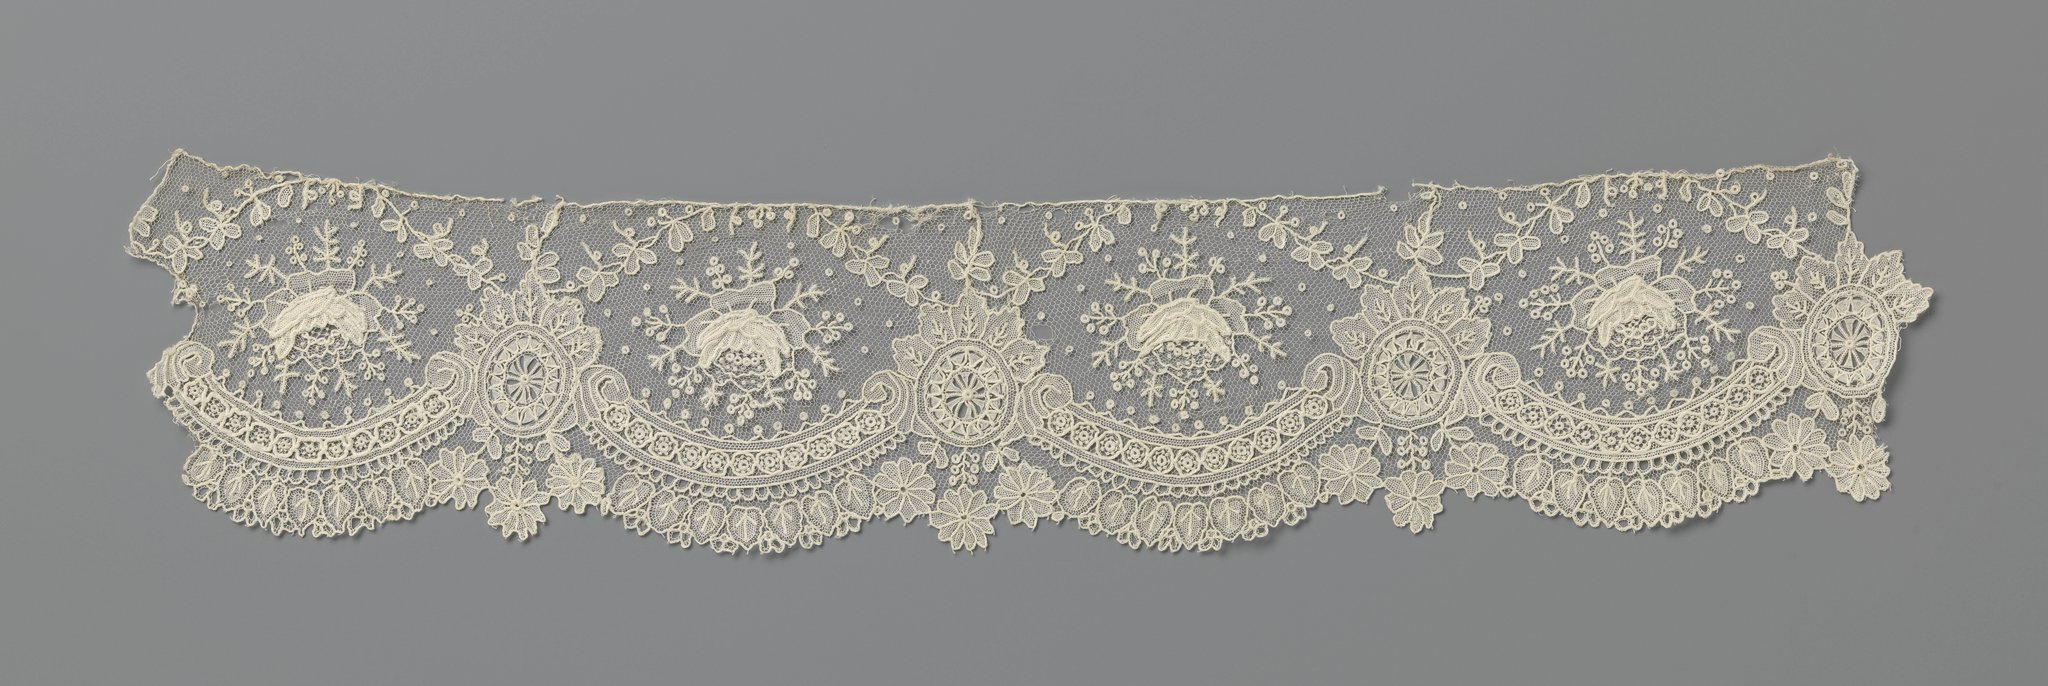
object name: strip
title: Strook naaldkant met hangende hartjes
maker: Anonymous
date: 1880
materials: linen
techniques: lace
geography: brussels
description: Strook naturelkleurig naaldkant: Brusselse gaaskant. Het zich herhalende patroon bestaat uit grote halfronde schulpen gevormd door aan elkaar geschakelde liggende c-voluten. Boven elk voluut staat één losse roos met een stralenkrans van korte takjes met besjes. De schakelpunten tussen de voluten worden gevormd door ovale medaillons, die met een bladkroon zijn versierd. Vanuit de bladkroon ontspringt een fijn slingertje dat met een boog over de roos naar het volgende medaillon loopt. De schulpenrand wordt gevormd door hangende hartvormige blaadjes onder de voluten afgewisseld door steeds drie afhangende madeliefjes onder de medaillons. De motieven zijn opgebouwd uit festonsteken en voorzien van reliëfcontouren. De rozen hebben reliëfblaadjes. De motieven zijn met elkaar verbonden door een fijne maasgrond, een gaaskantgrond, waarop enkele moesjes zijn aangebracht. In de rozen en medaillons zijn siersteken toegepast. De bovenzijde van de strook is recht afgewerkt.